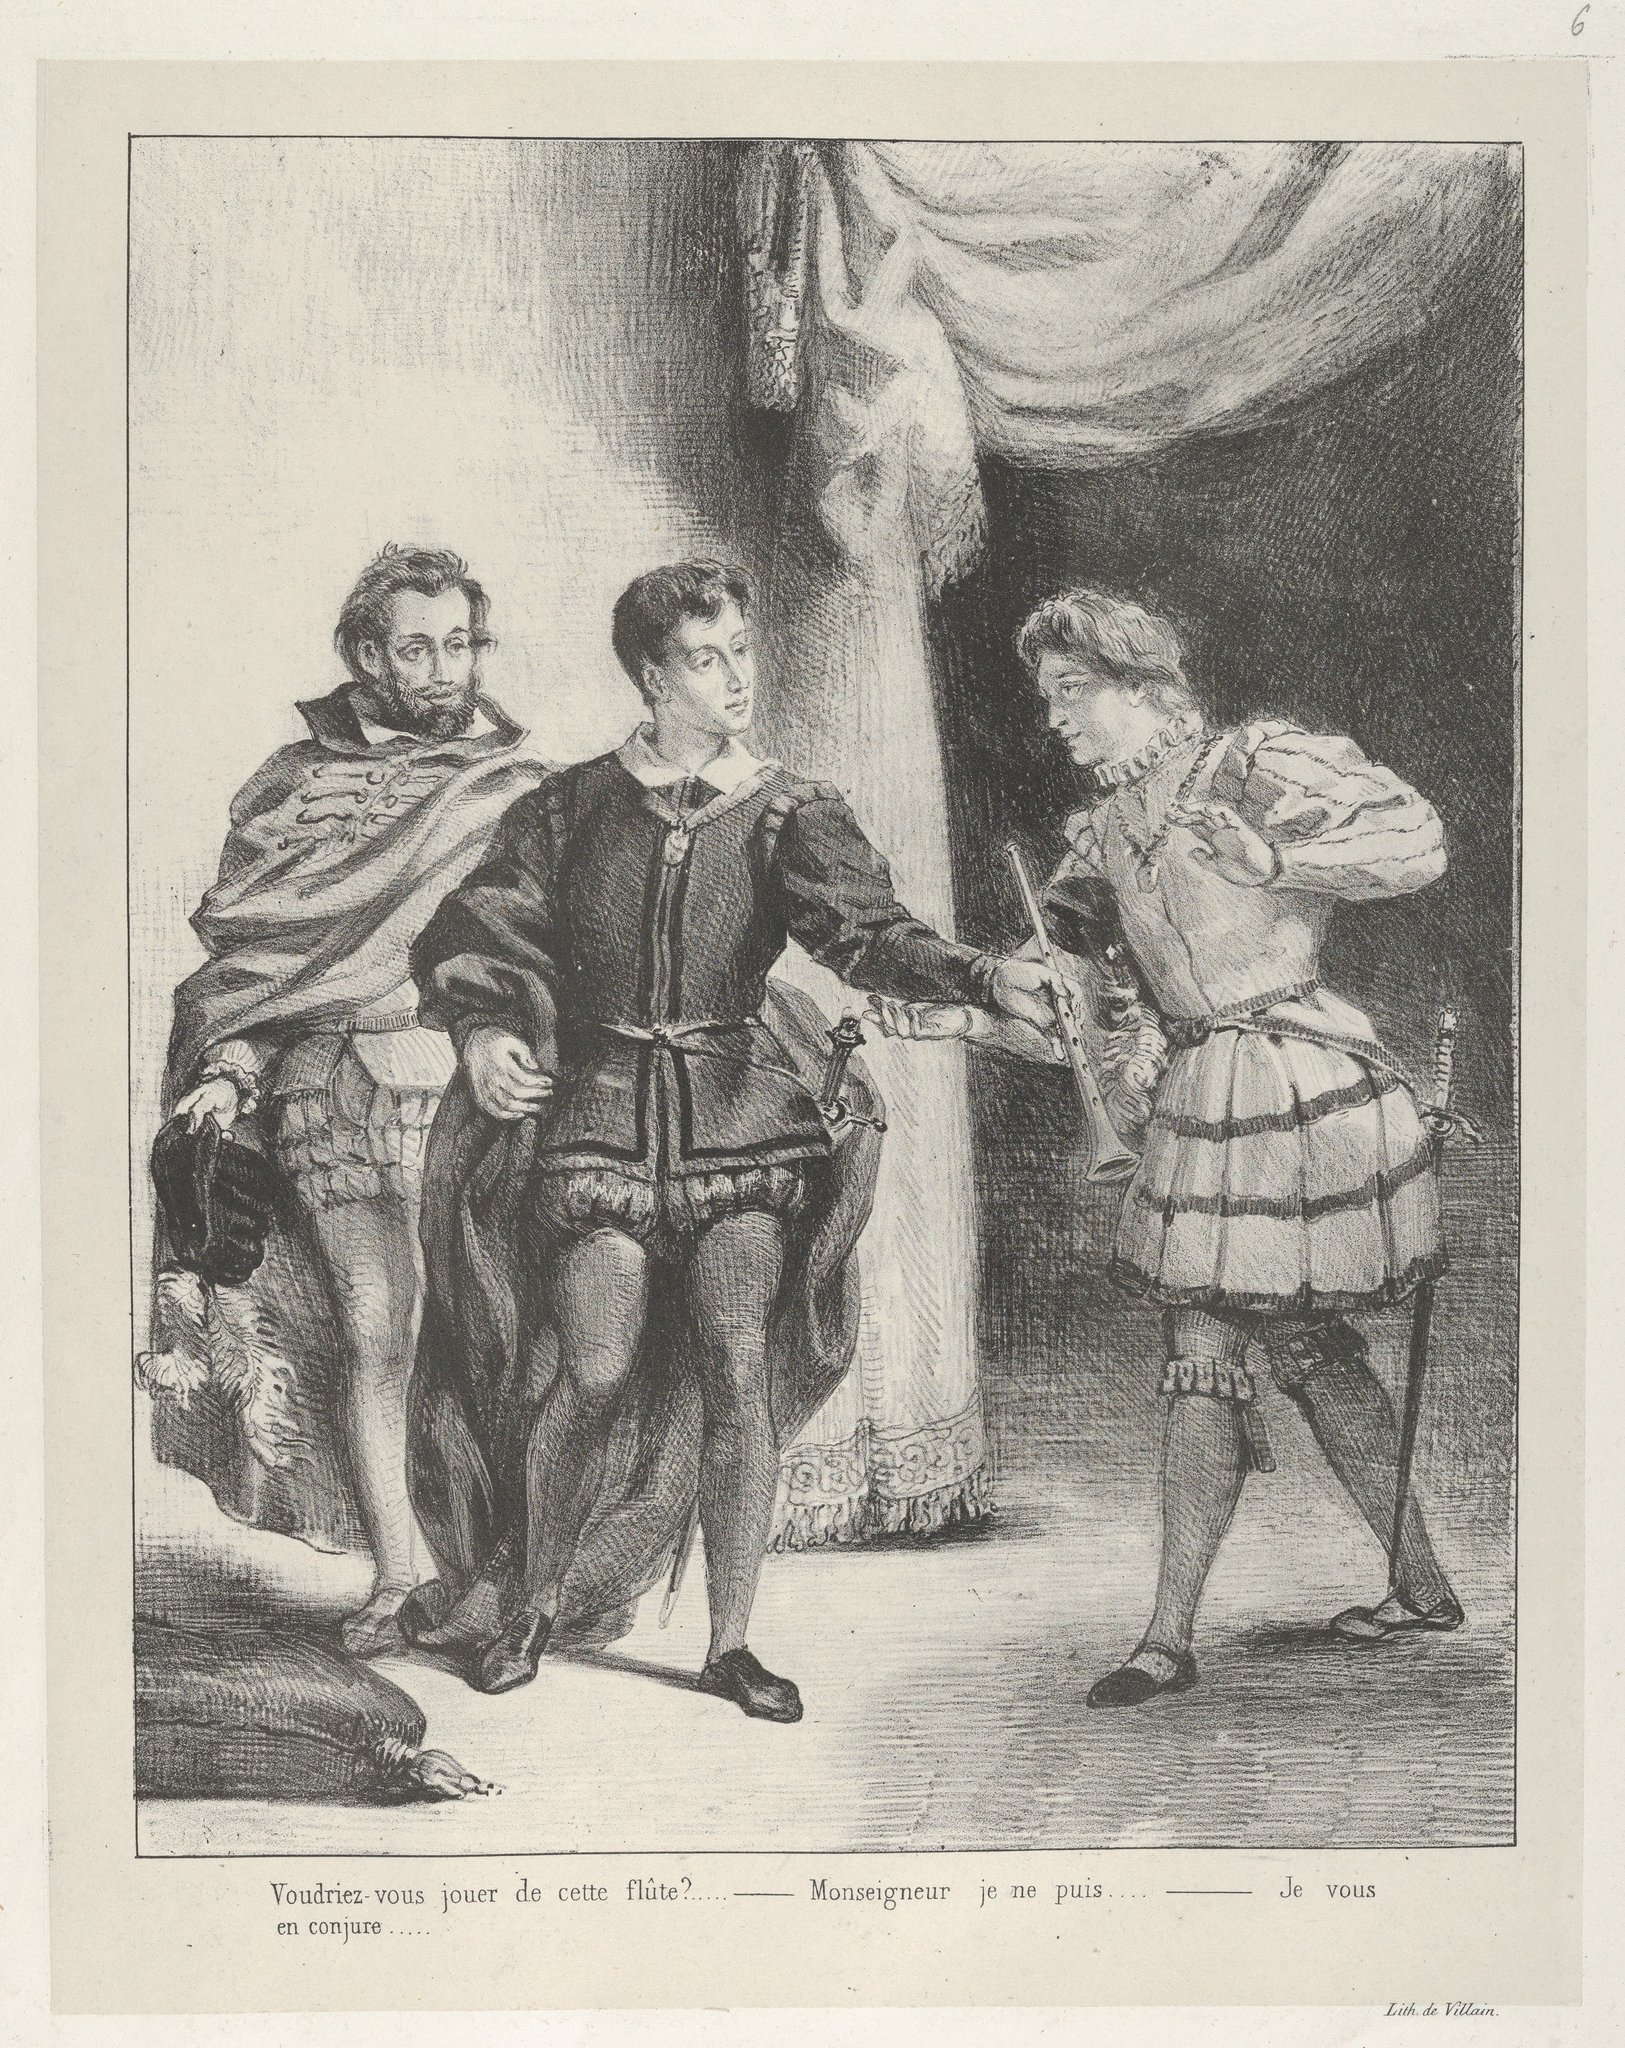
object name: print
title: Hamlet and Guildenstern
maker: eugène delacroix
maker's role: artist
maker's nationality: french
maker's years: 1798-1863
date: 1834-1843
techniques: lithograph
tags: shakespeare,men,hamlet